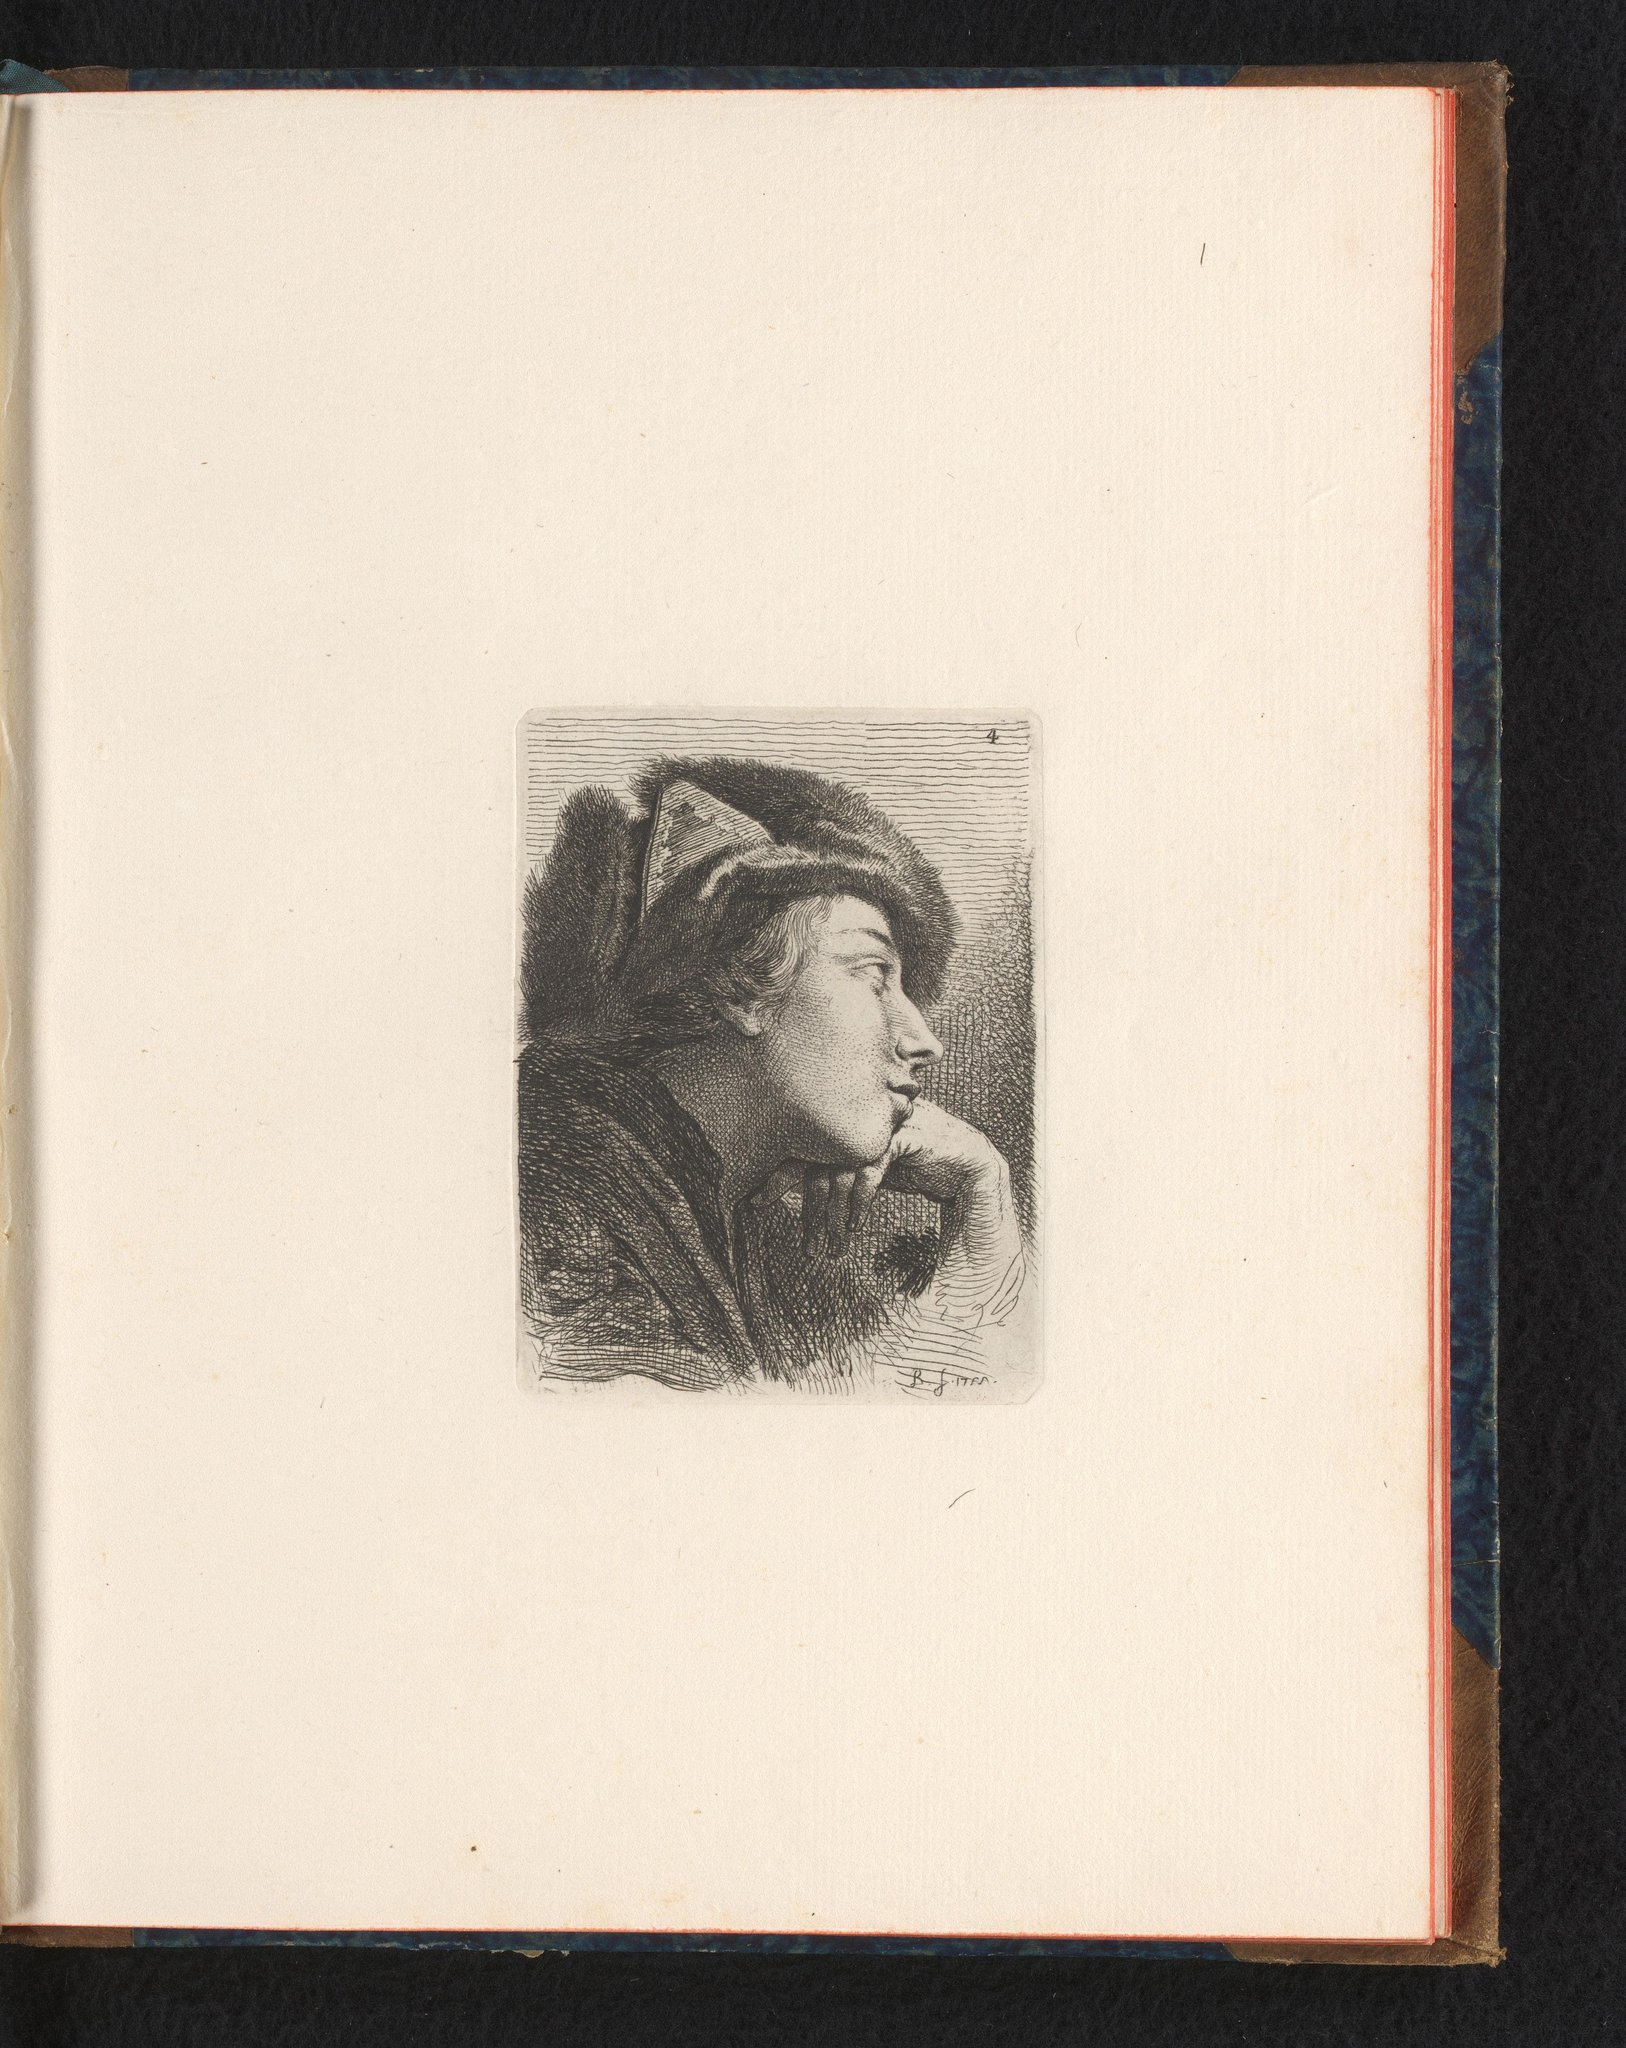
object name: print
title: Hoofd van een jongeman naar rechts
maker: benigno bossi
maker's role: print maker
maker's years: 1727-1792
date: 1755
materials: paper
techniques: etching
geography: parma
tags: head (human), head held in the hand(s), with elbows leaning on an elevation or on the knees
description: De prent is waarschijnlijk in een eerdere staat uitgegeven onder de serietitel: Prove d"aqua forte. De prent is in dezelfde staat ook uitgegeven met de serietitel: Raccolta di teste inventate, disegnate ed incise da Benigno Bossi.